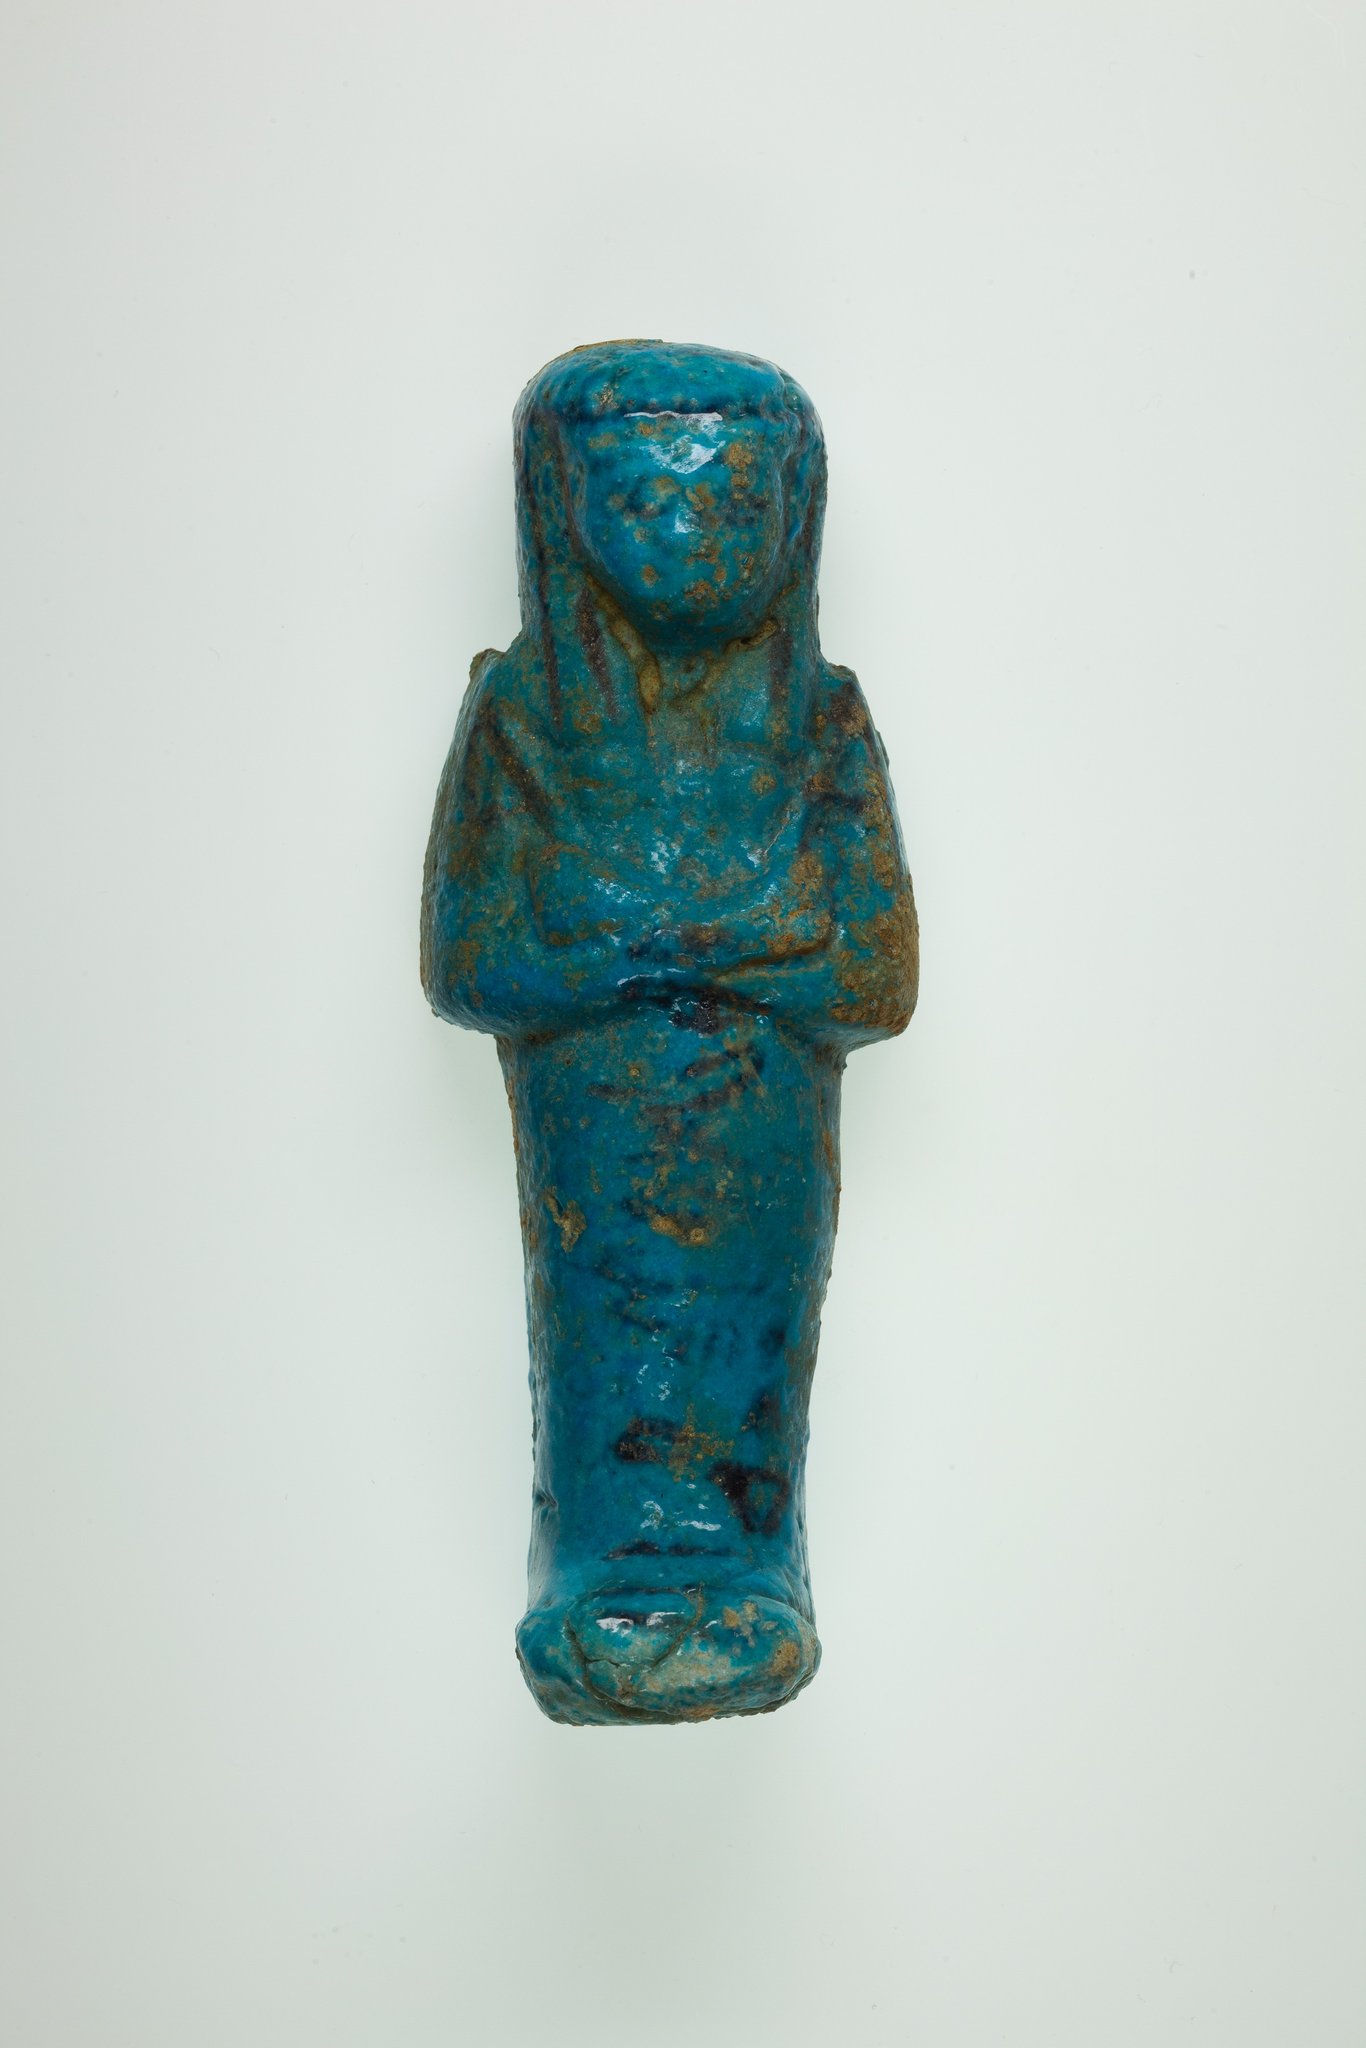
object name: shabti, henettawy c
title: Worker Shabti of Henettawy (C), Daughter of Isetemkheb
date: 990-970 BCE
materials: faience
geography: egypt